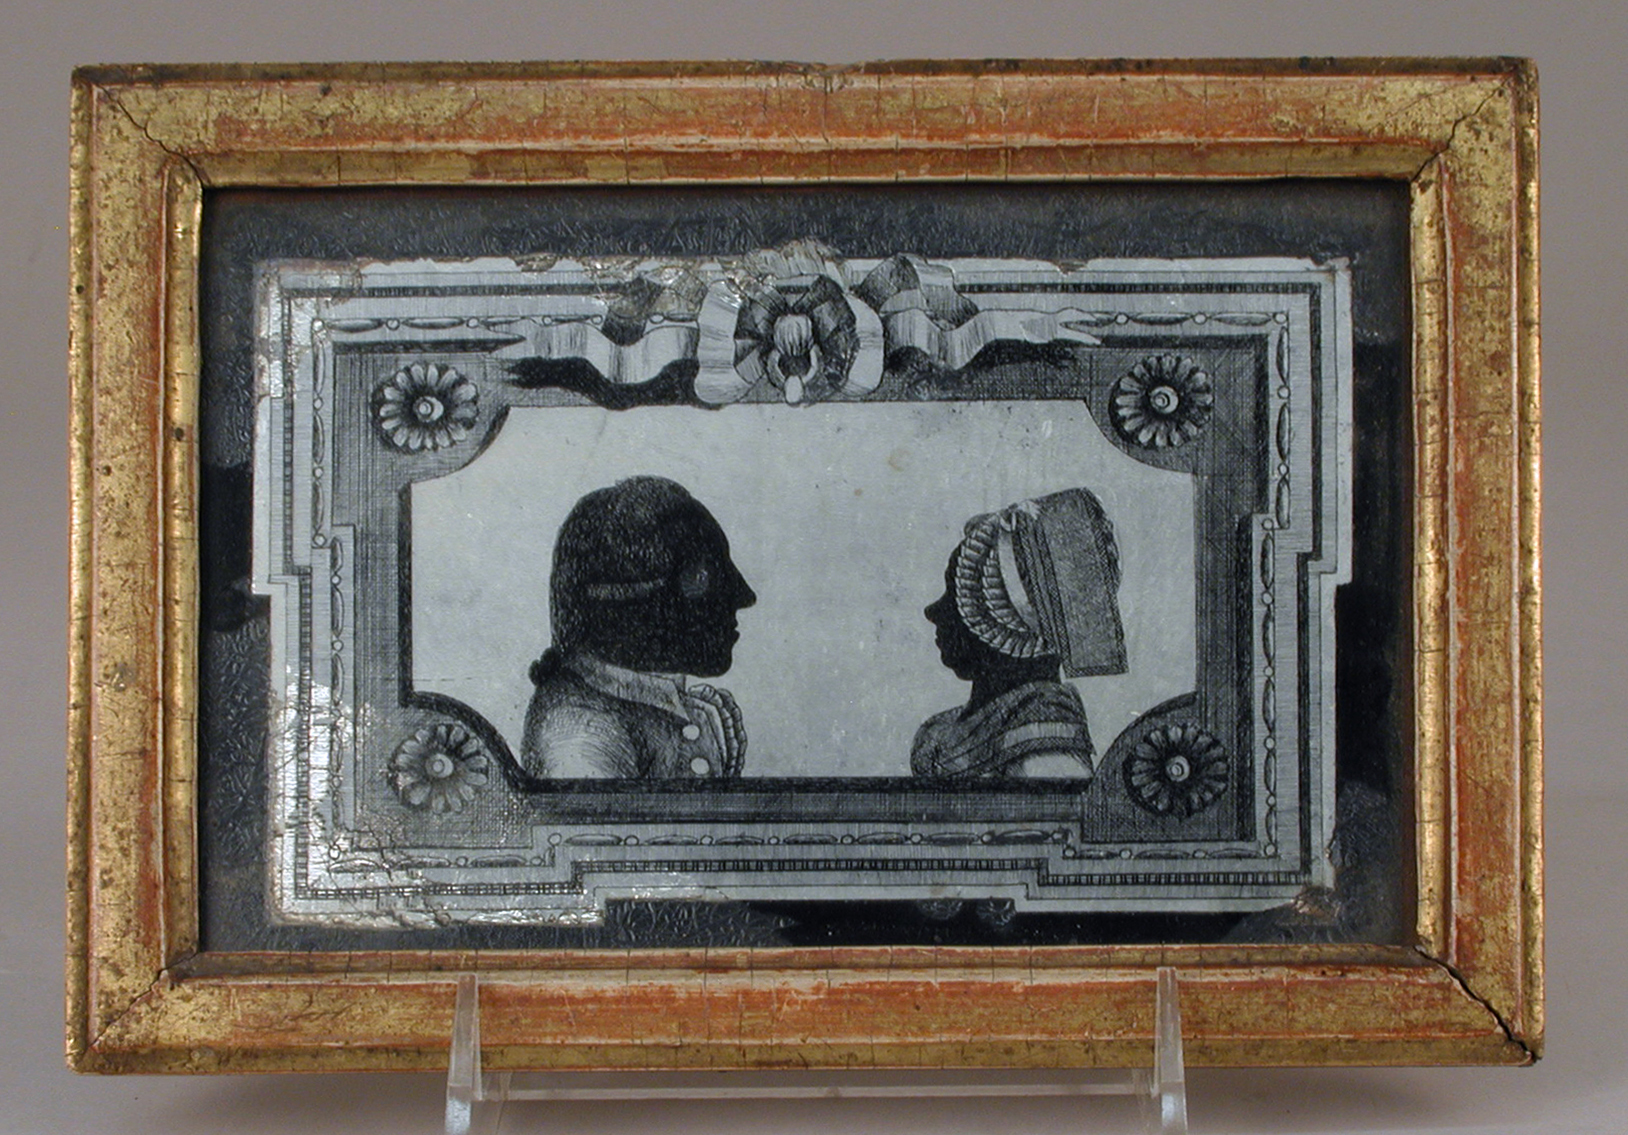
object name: panel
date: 1701-1800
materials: glass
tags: men,profiles,women